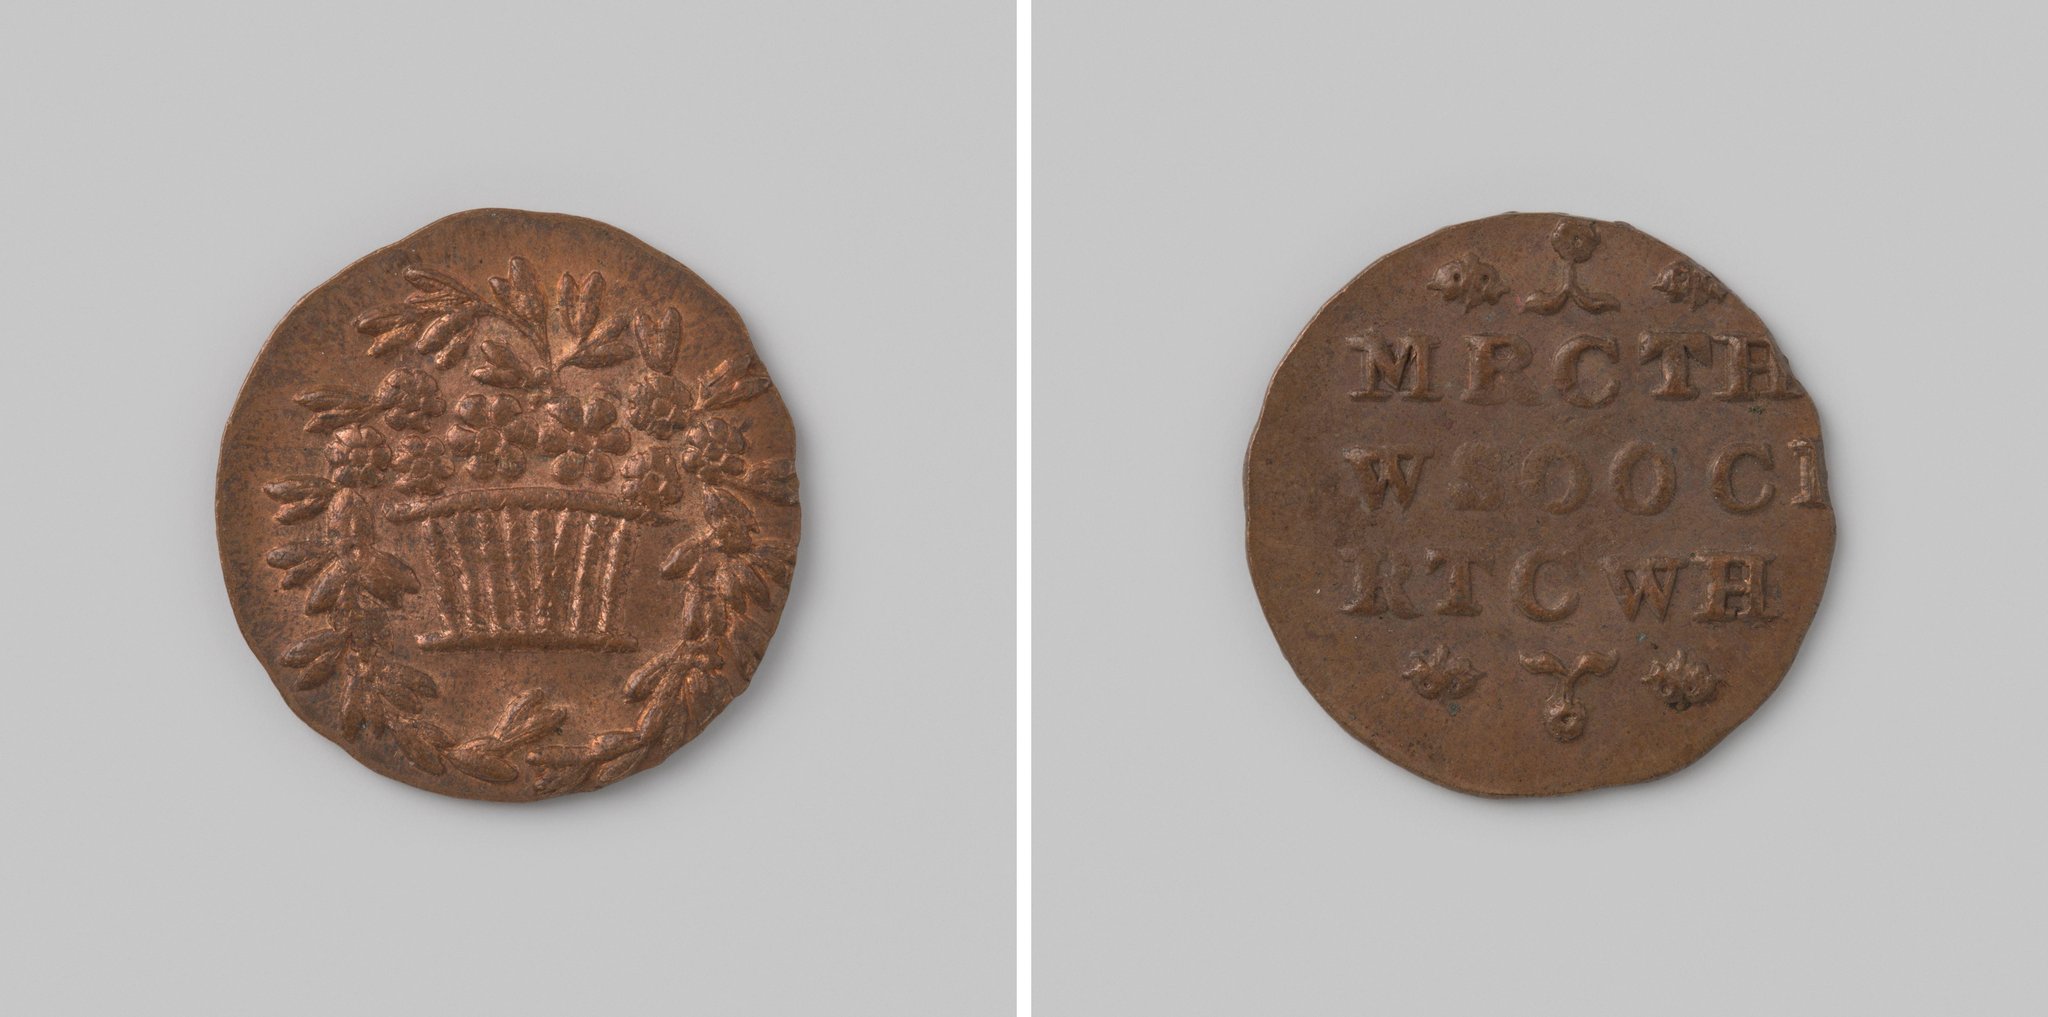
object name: coin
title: Bloemenmandduit voor Nederlands Indië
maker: Anonymous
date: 1836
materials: copper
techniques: striking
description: Koperen proefmunt. Voorzijde: bloemenmand met bloemen. Keerzijde: drieregelig opschrift, waarboven en waaronder versiering. Gladde rand.